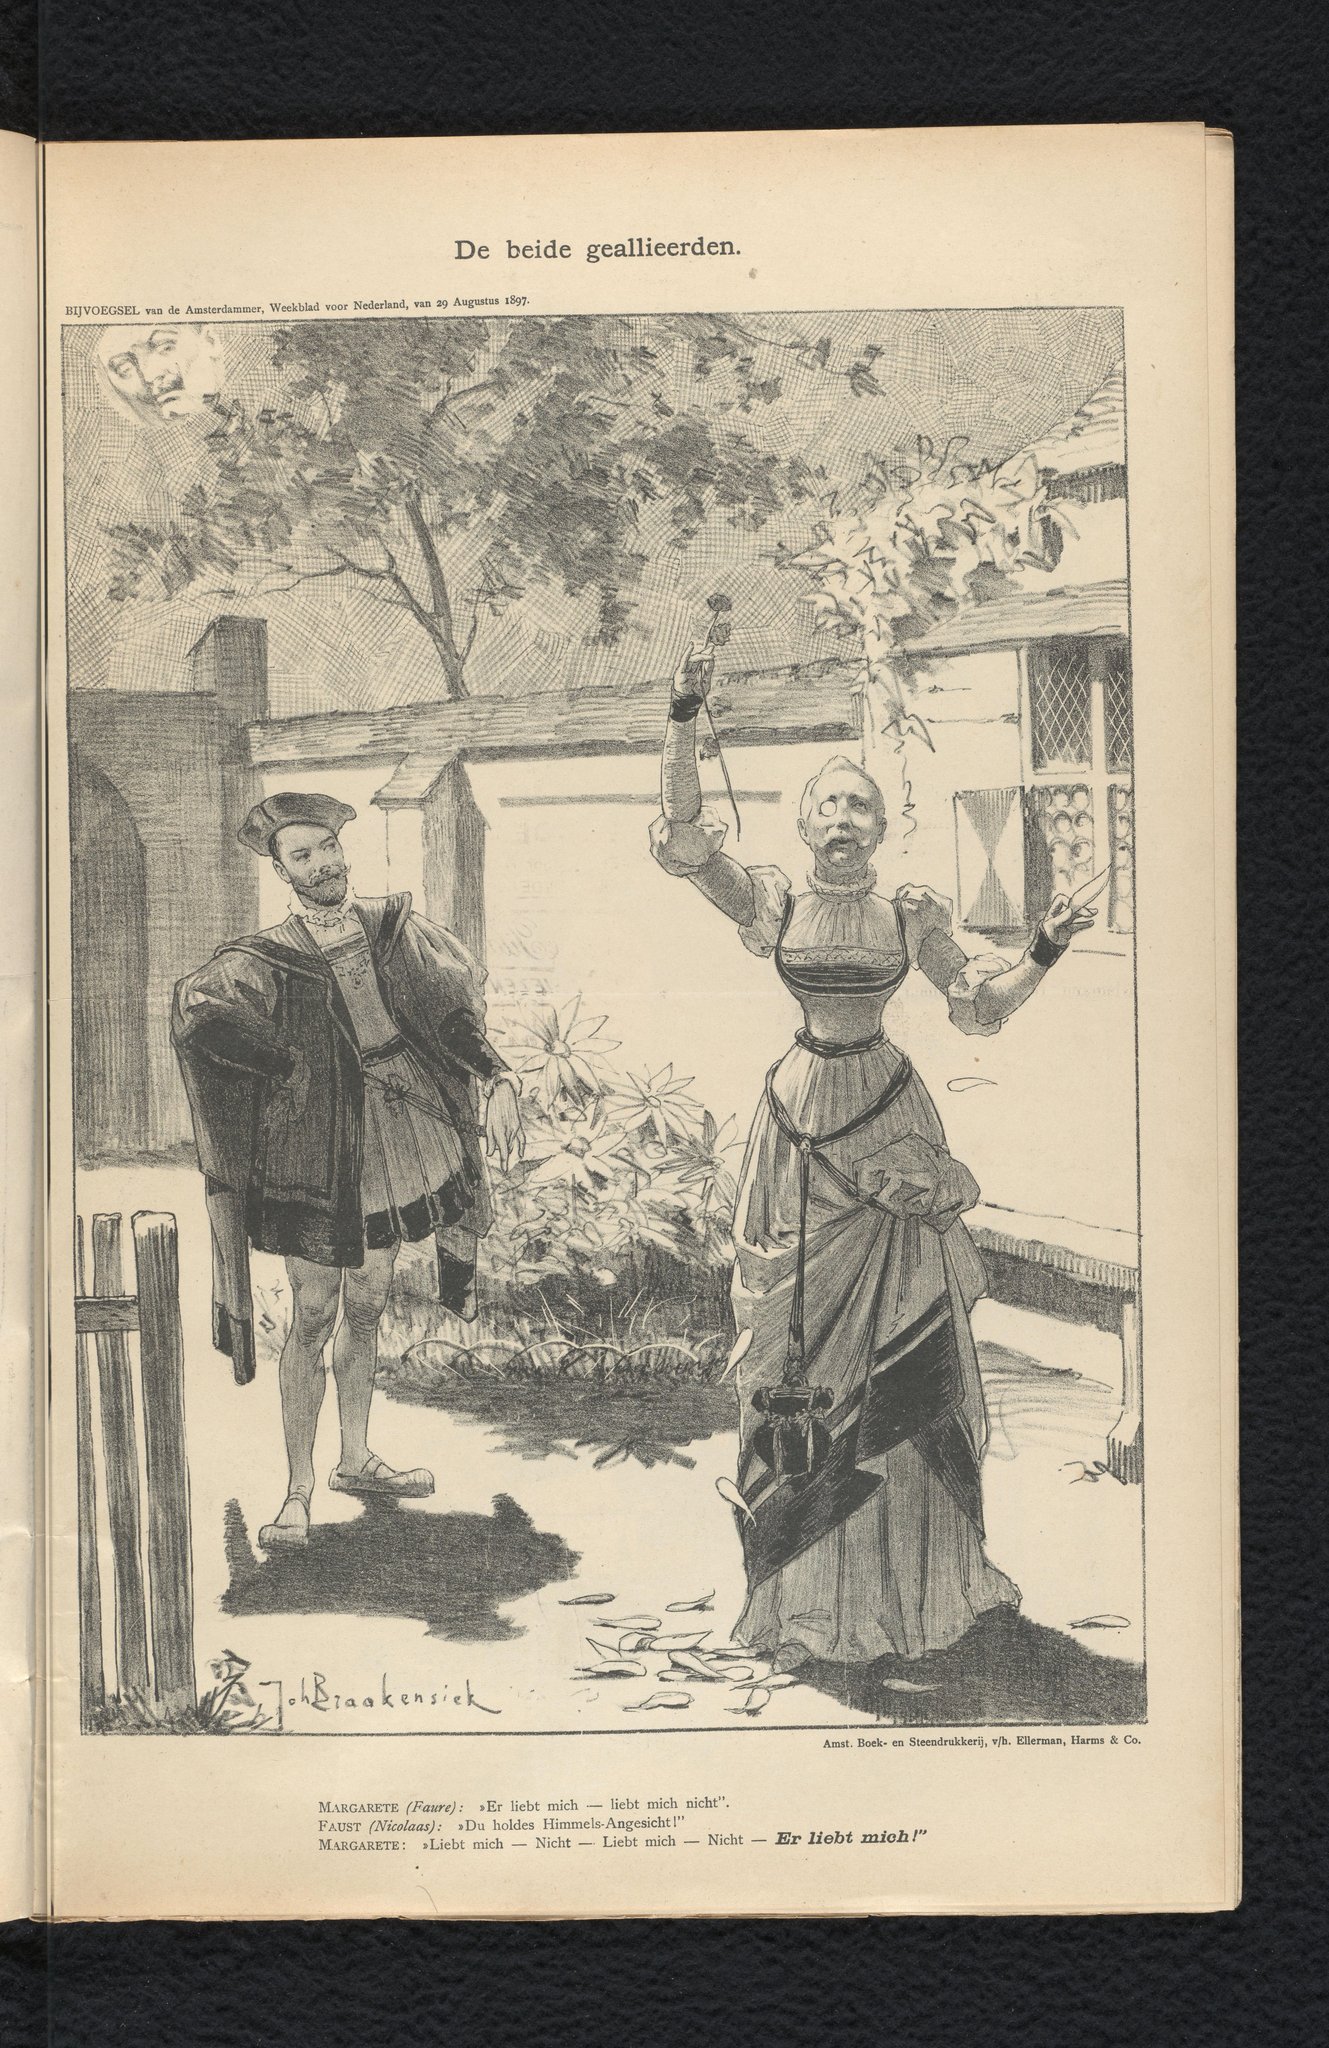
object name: cartoon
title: De beide geallieerden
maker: johan braakensiek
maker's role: draughtsman, print maker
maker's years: 1858-1940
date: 1897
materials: paper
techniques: lithograph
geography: netherlands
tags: personifications of countries, nations, states, districts, etc., faust, (scenes from) specific works of literature: goethe, faust, political caricatures and satires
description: De Russische tsaar Nicolaas II met de Franse president Faure als Faust en Margarete.